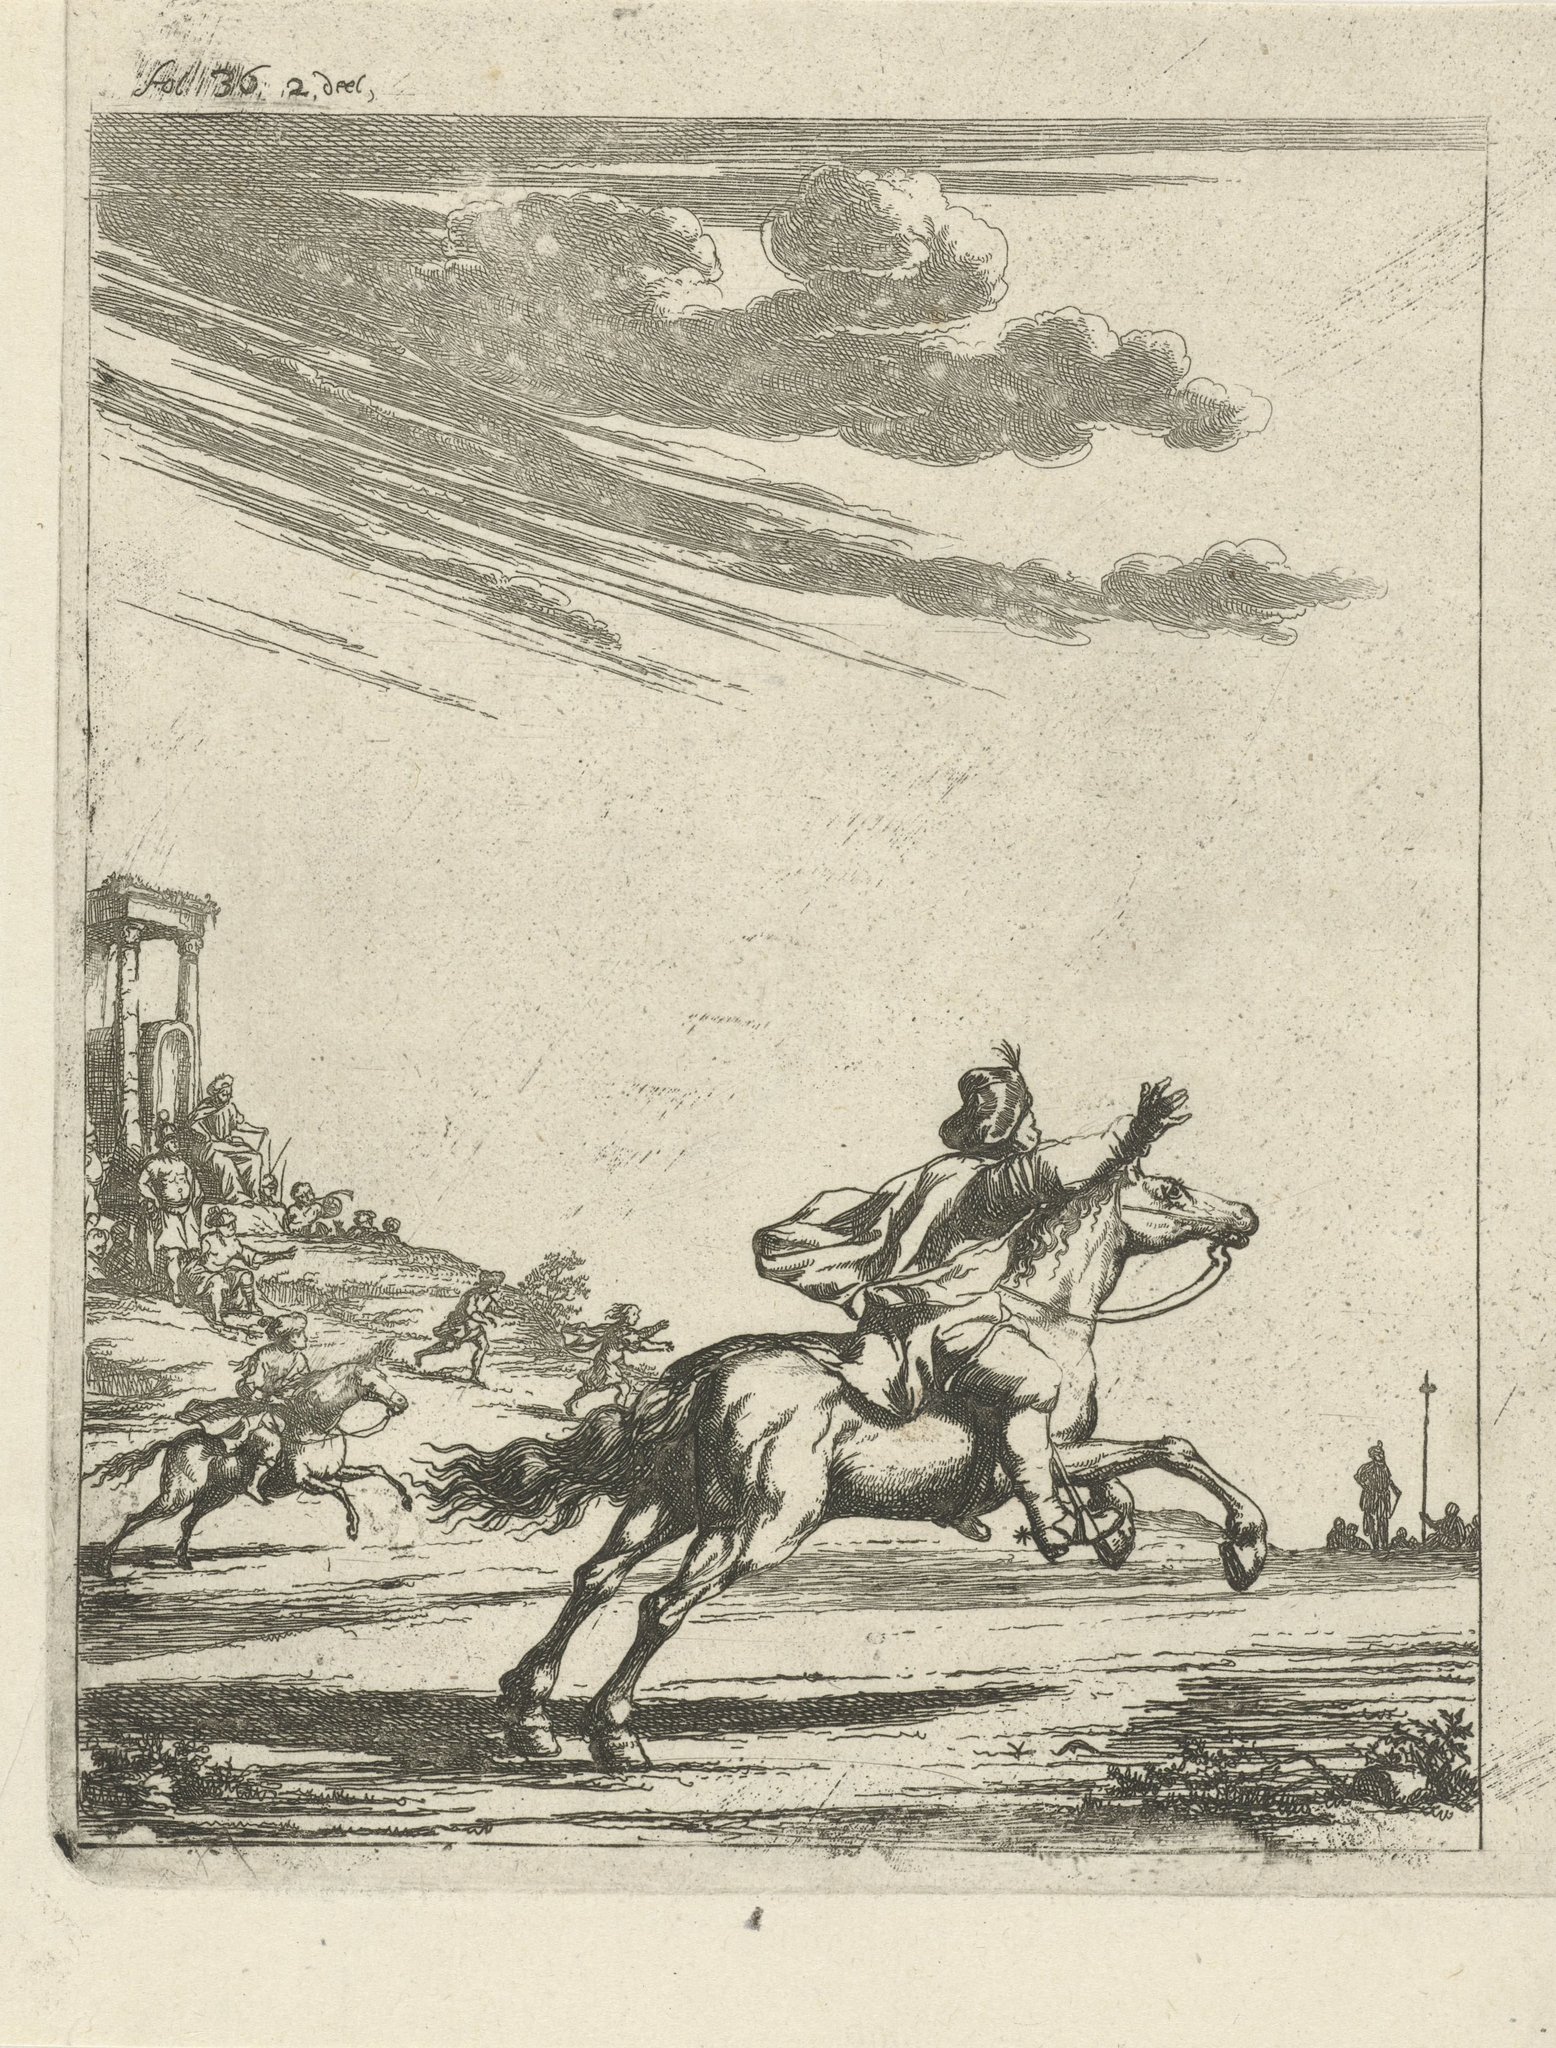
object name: print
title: Ruiters in een landschap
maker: arnold houbraken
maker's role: draughtsman, painter, print maker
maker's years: 1660-1719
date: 1681-1683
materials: paper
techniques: etching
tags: riding a horse, ass, or mule; rider, horseman, dale, valley, throne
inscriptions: collector's mark: Lugt 2228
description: In een landschap galopperen twee ruiters. Linksop een heuvel een figuur op een troon, omringd door enkele krijslieden. Linksboven: fol. 36, 2 deel. Prent gebruikt in een boek van Lambert van den Bos met in totaal twintig prenten van Arnold Houbraken.